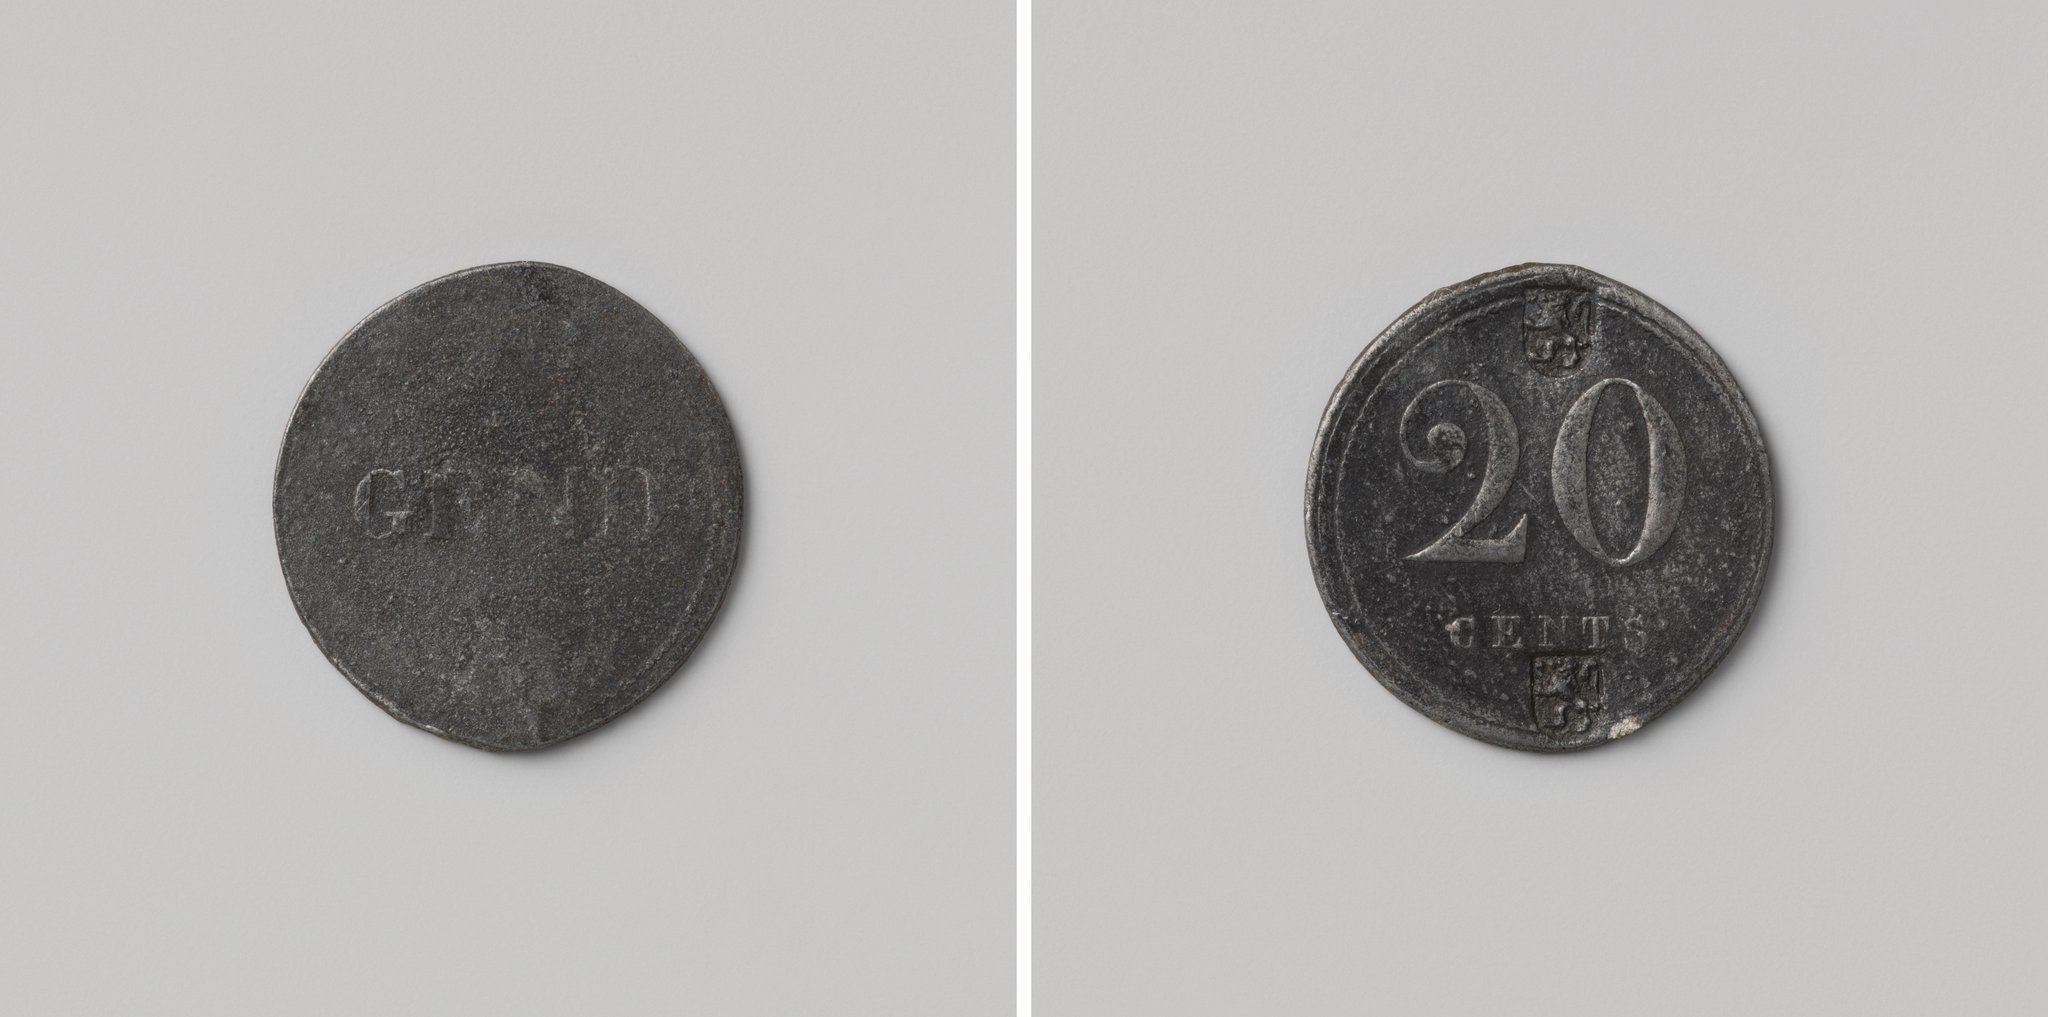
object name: huismunt prison money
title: Strafgevangenis te Gent, huismunt ter waarde van twintig cents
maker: Anonymous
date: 1826-1833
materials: zinc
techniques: striking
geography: brussels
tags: ghent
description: Zinken betaalpenning. Voorzijde: opschrift. Keerzijde: waardeaanduiding; onder en boven een klop: ingestempeld wapenschild